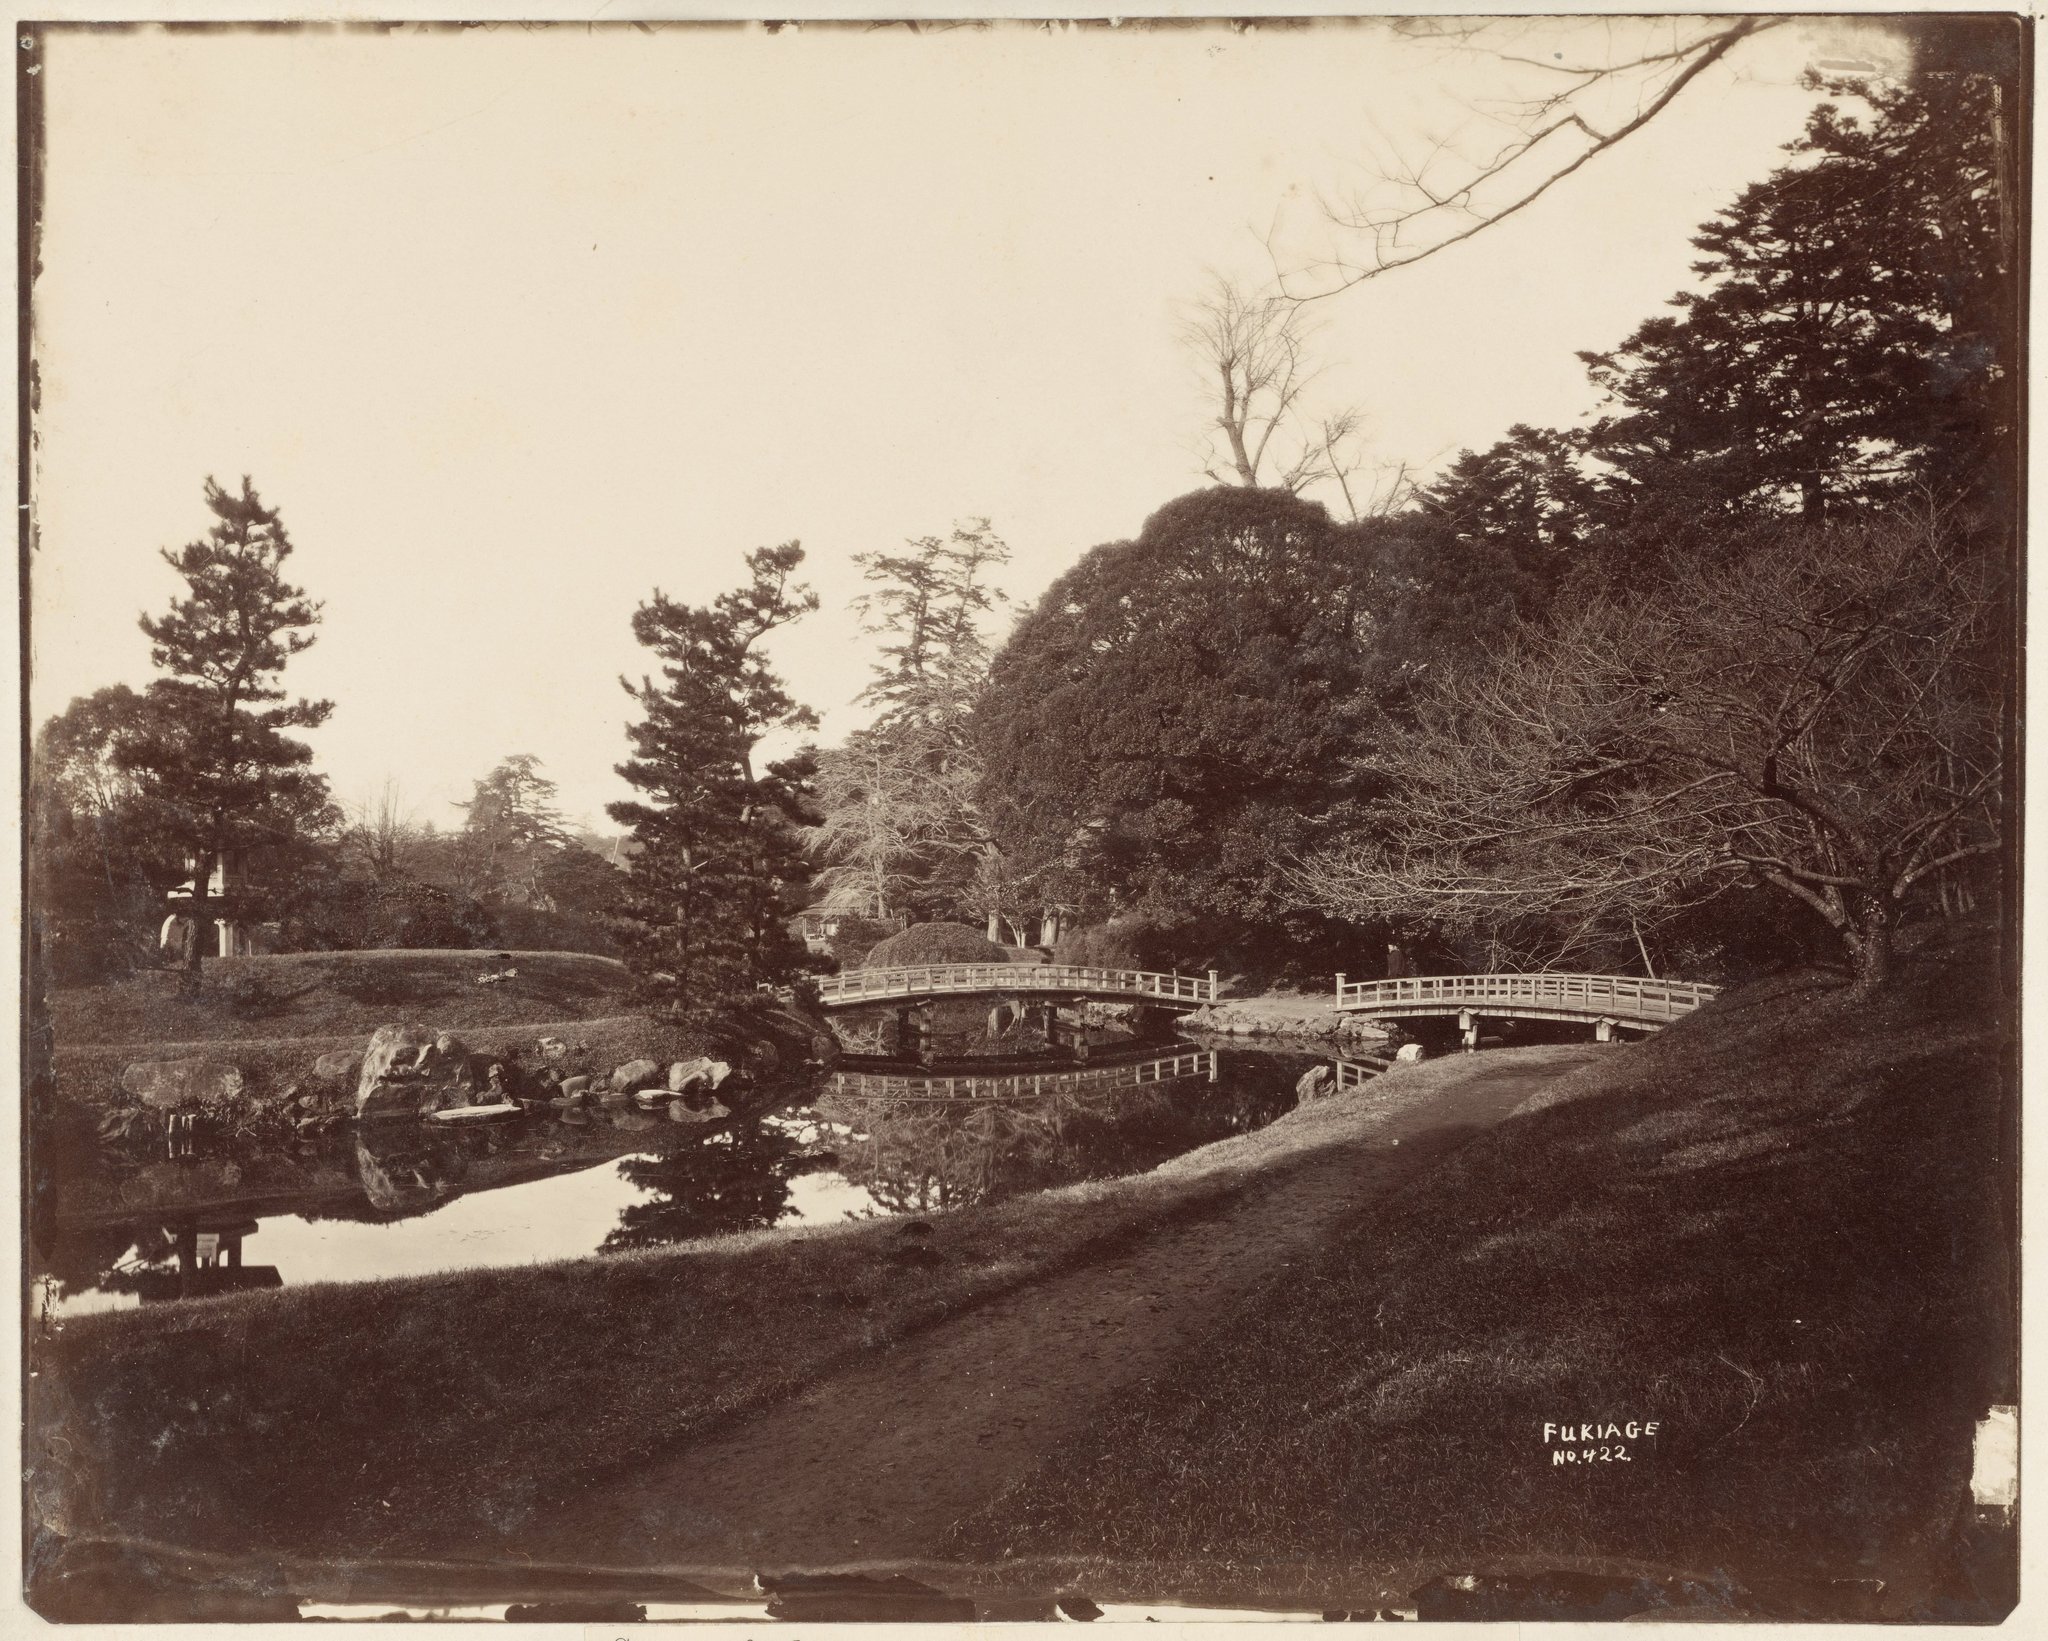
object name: photograph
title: Gezicht in de Fukiagetuin in Tokyo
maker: Anonymous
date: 1884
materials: cardboard, paper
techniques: albumen print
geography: tokyo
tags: garden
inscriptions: inscription: ‘FUKIAGE/ no. 422.’